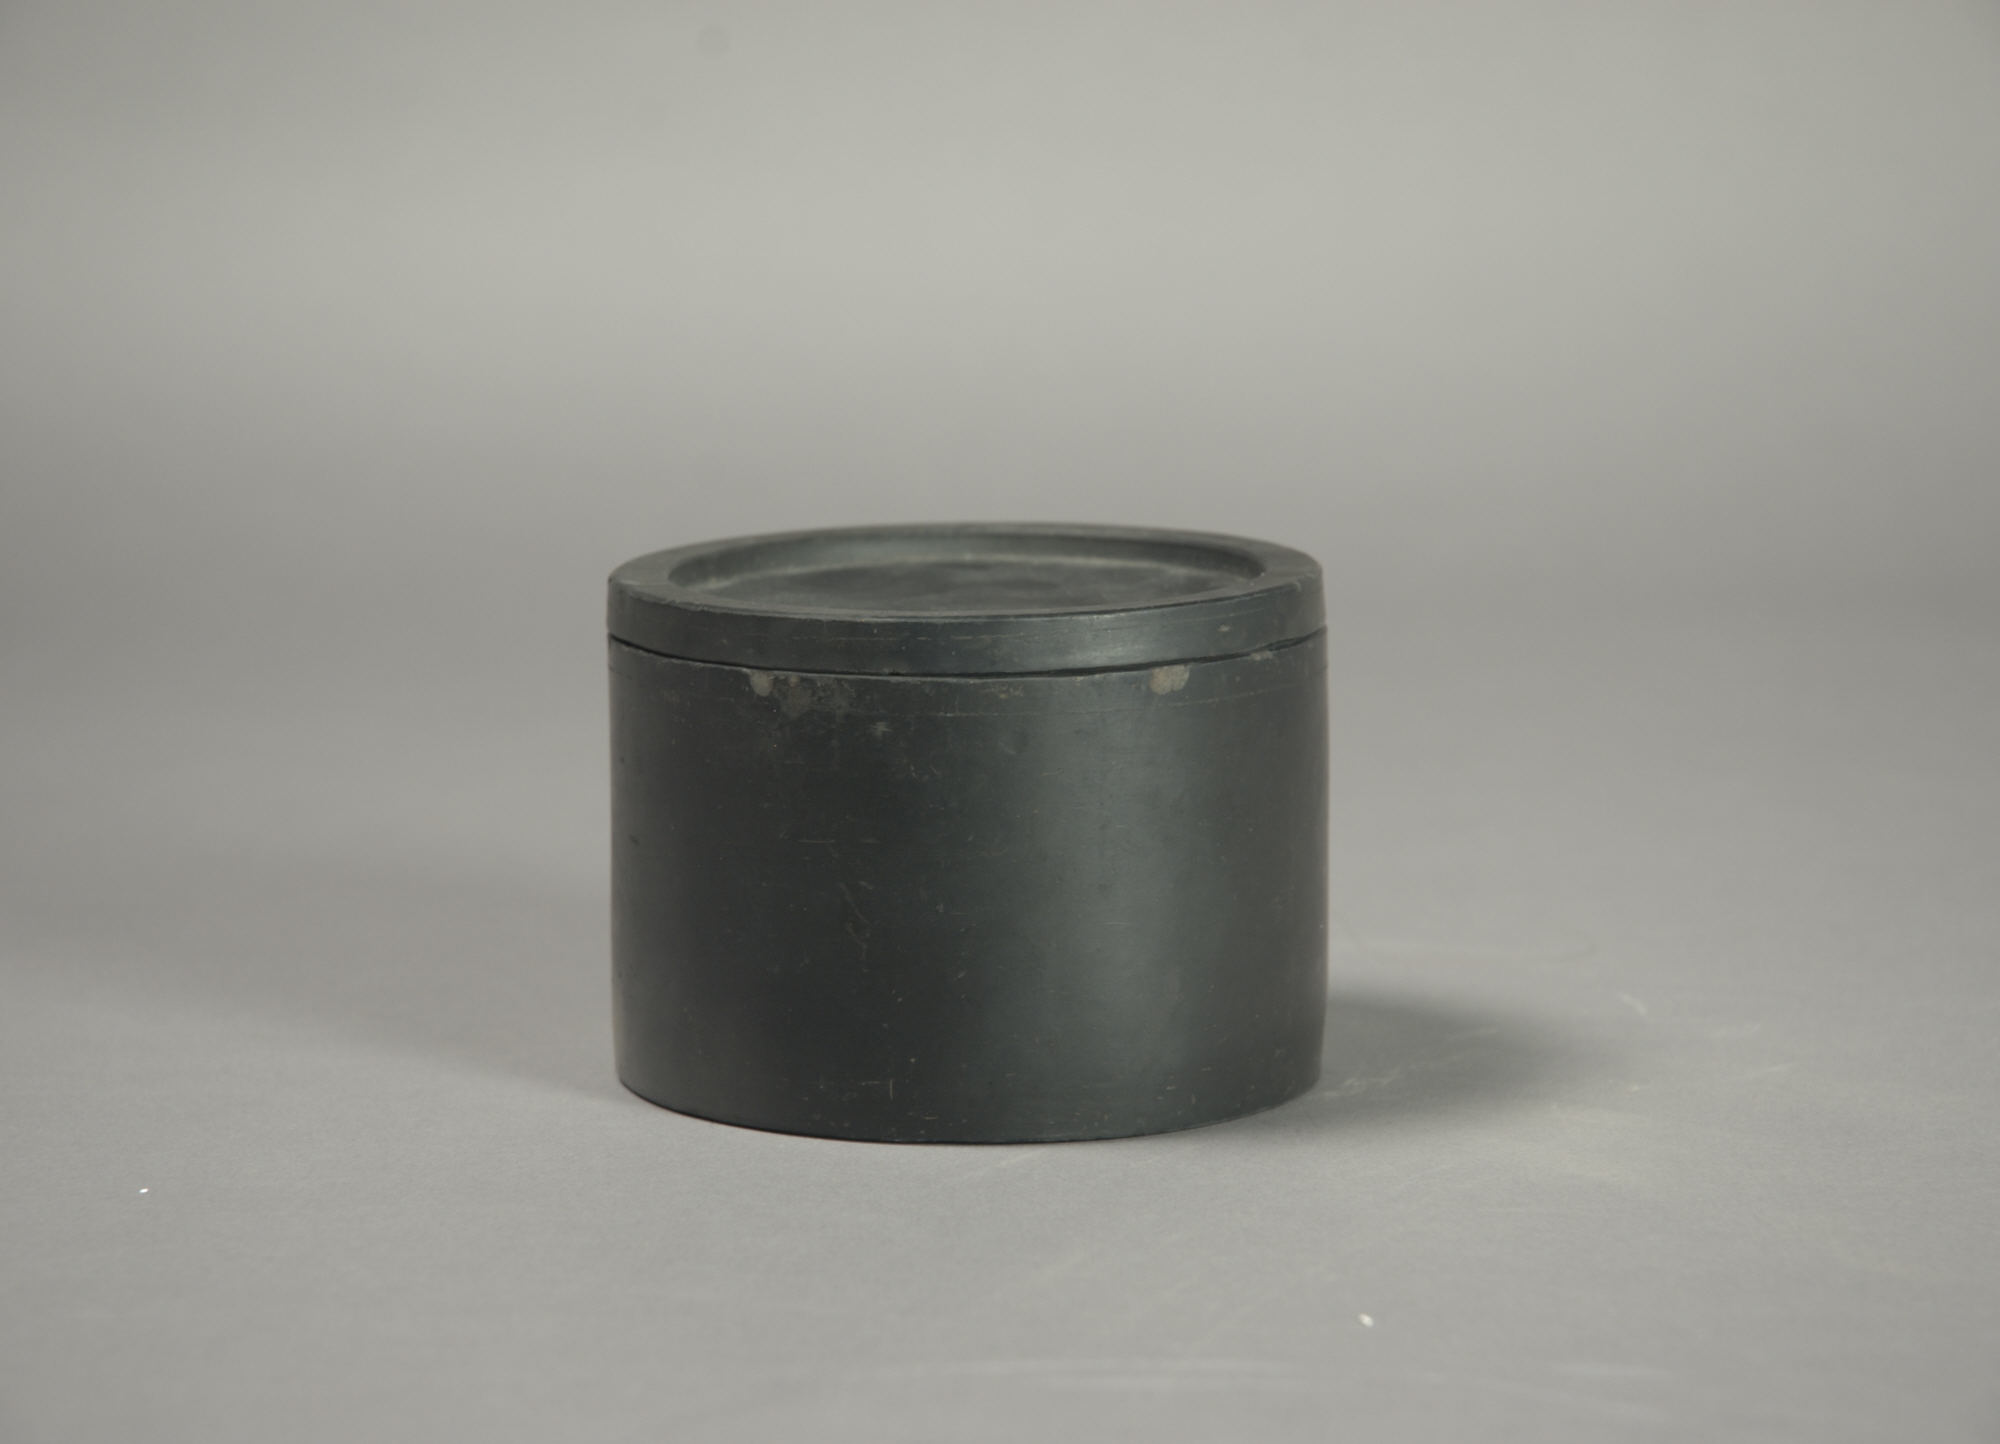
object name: cricket box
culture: chinese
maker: wang tonghe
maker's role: artist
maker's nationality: chinese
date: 1867-1933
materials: earthenware